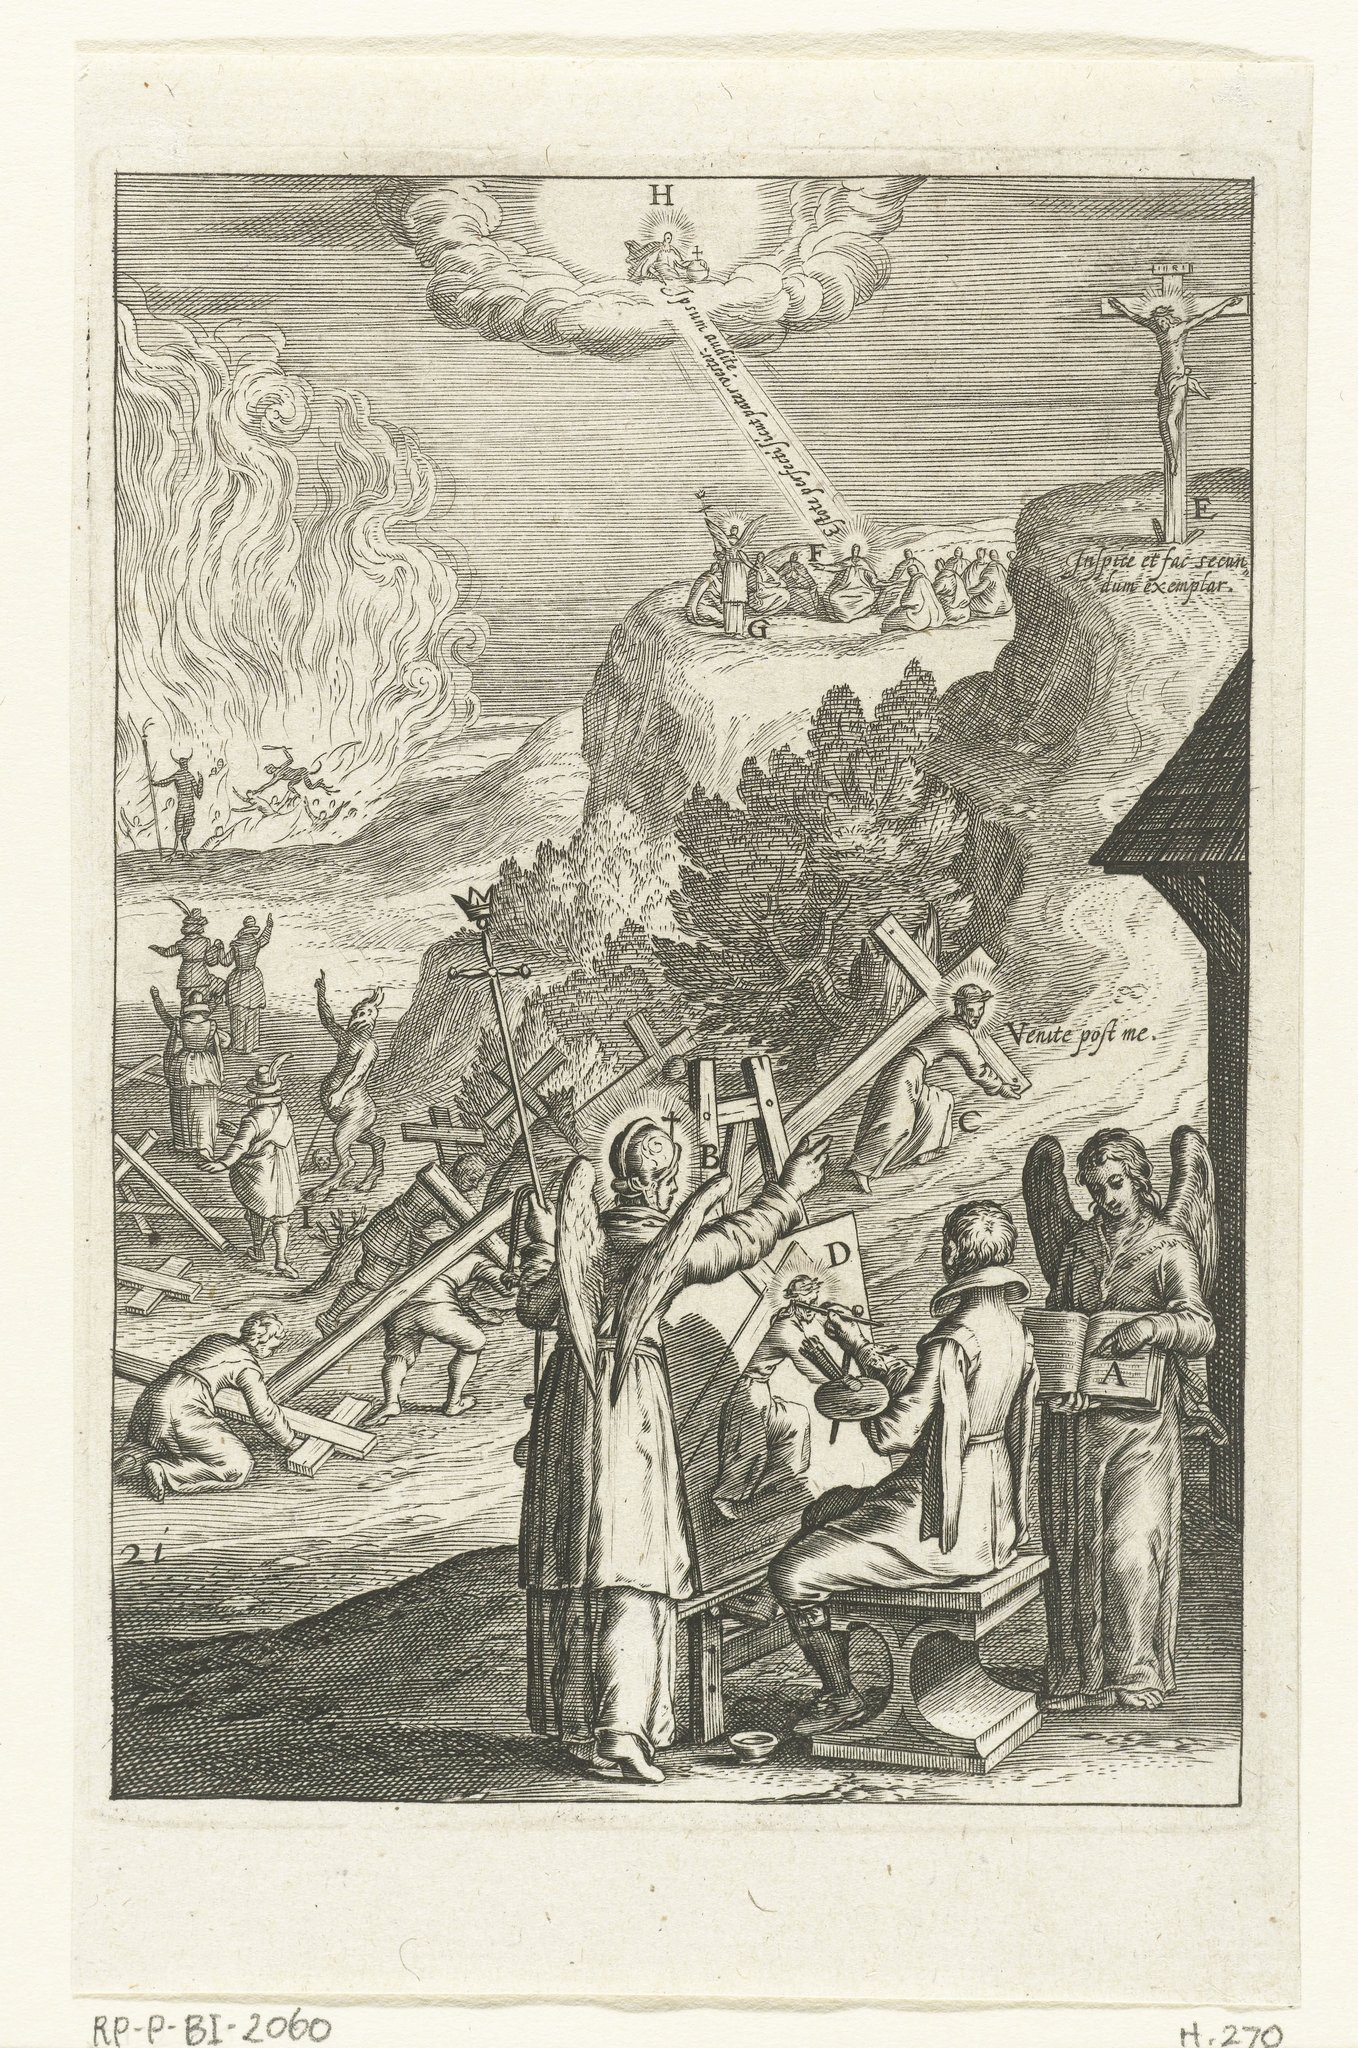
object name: print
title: Den wech des eeuwich levens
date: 1620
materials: paper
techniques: engraving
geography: antwerp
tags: the life of man, from pilate's palace to golgotha: the procession to calvary (matthew 27:31-33; mark 15:20-22; luke 23:26-33; john 19:17)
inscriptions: collector's mark: Lugt 2228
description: Een man schildert op aanwijzing van een engel het portret van Christus op de kruisweg. De man stelt daarmee een voorbeeld voor zichzelf hoe ook hij in deugd kan leven, aldus het meditatievoorschrift in de uitgave. In het landschap draagt Christus zijn kruis de Calvarieberg op en velen volgen hem met een eigen kruis.